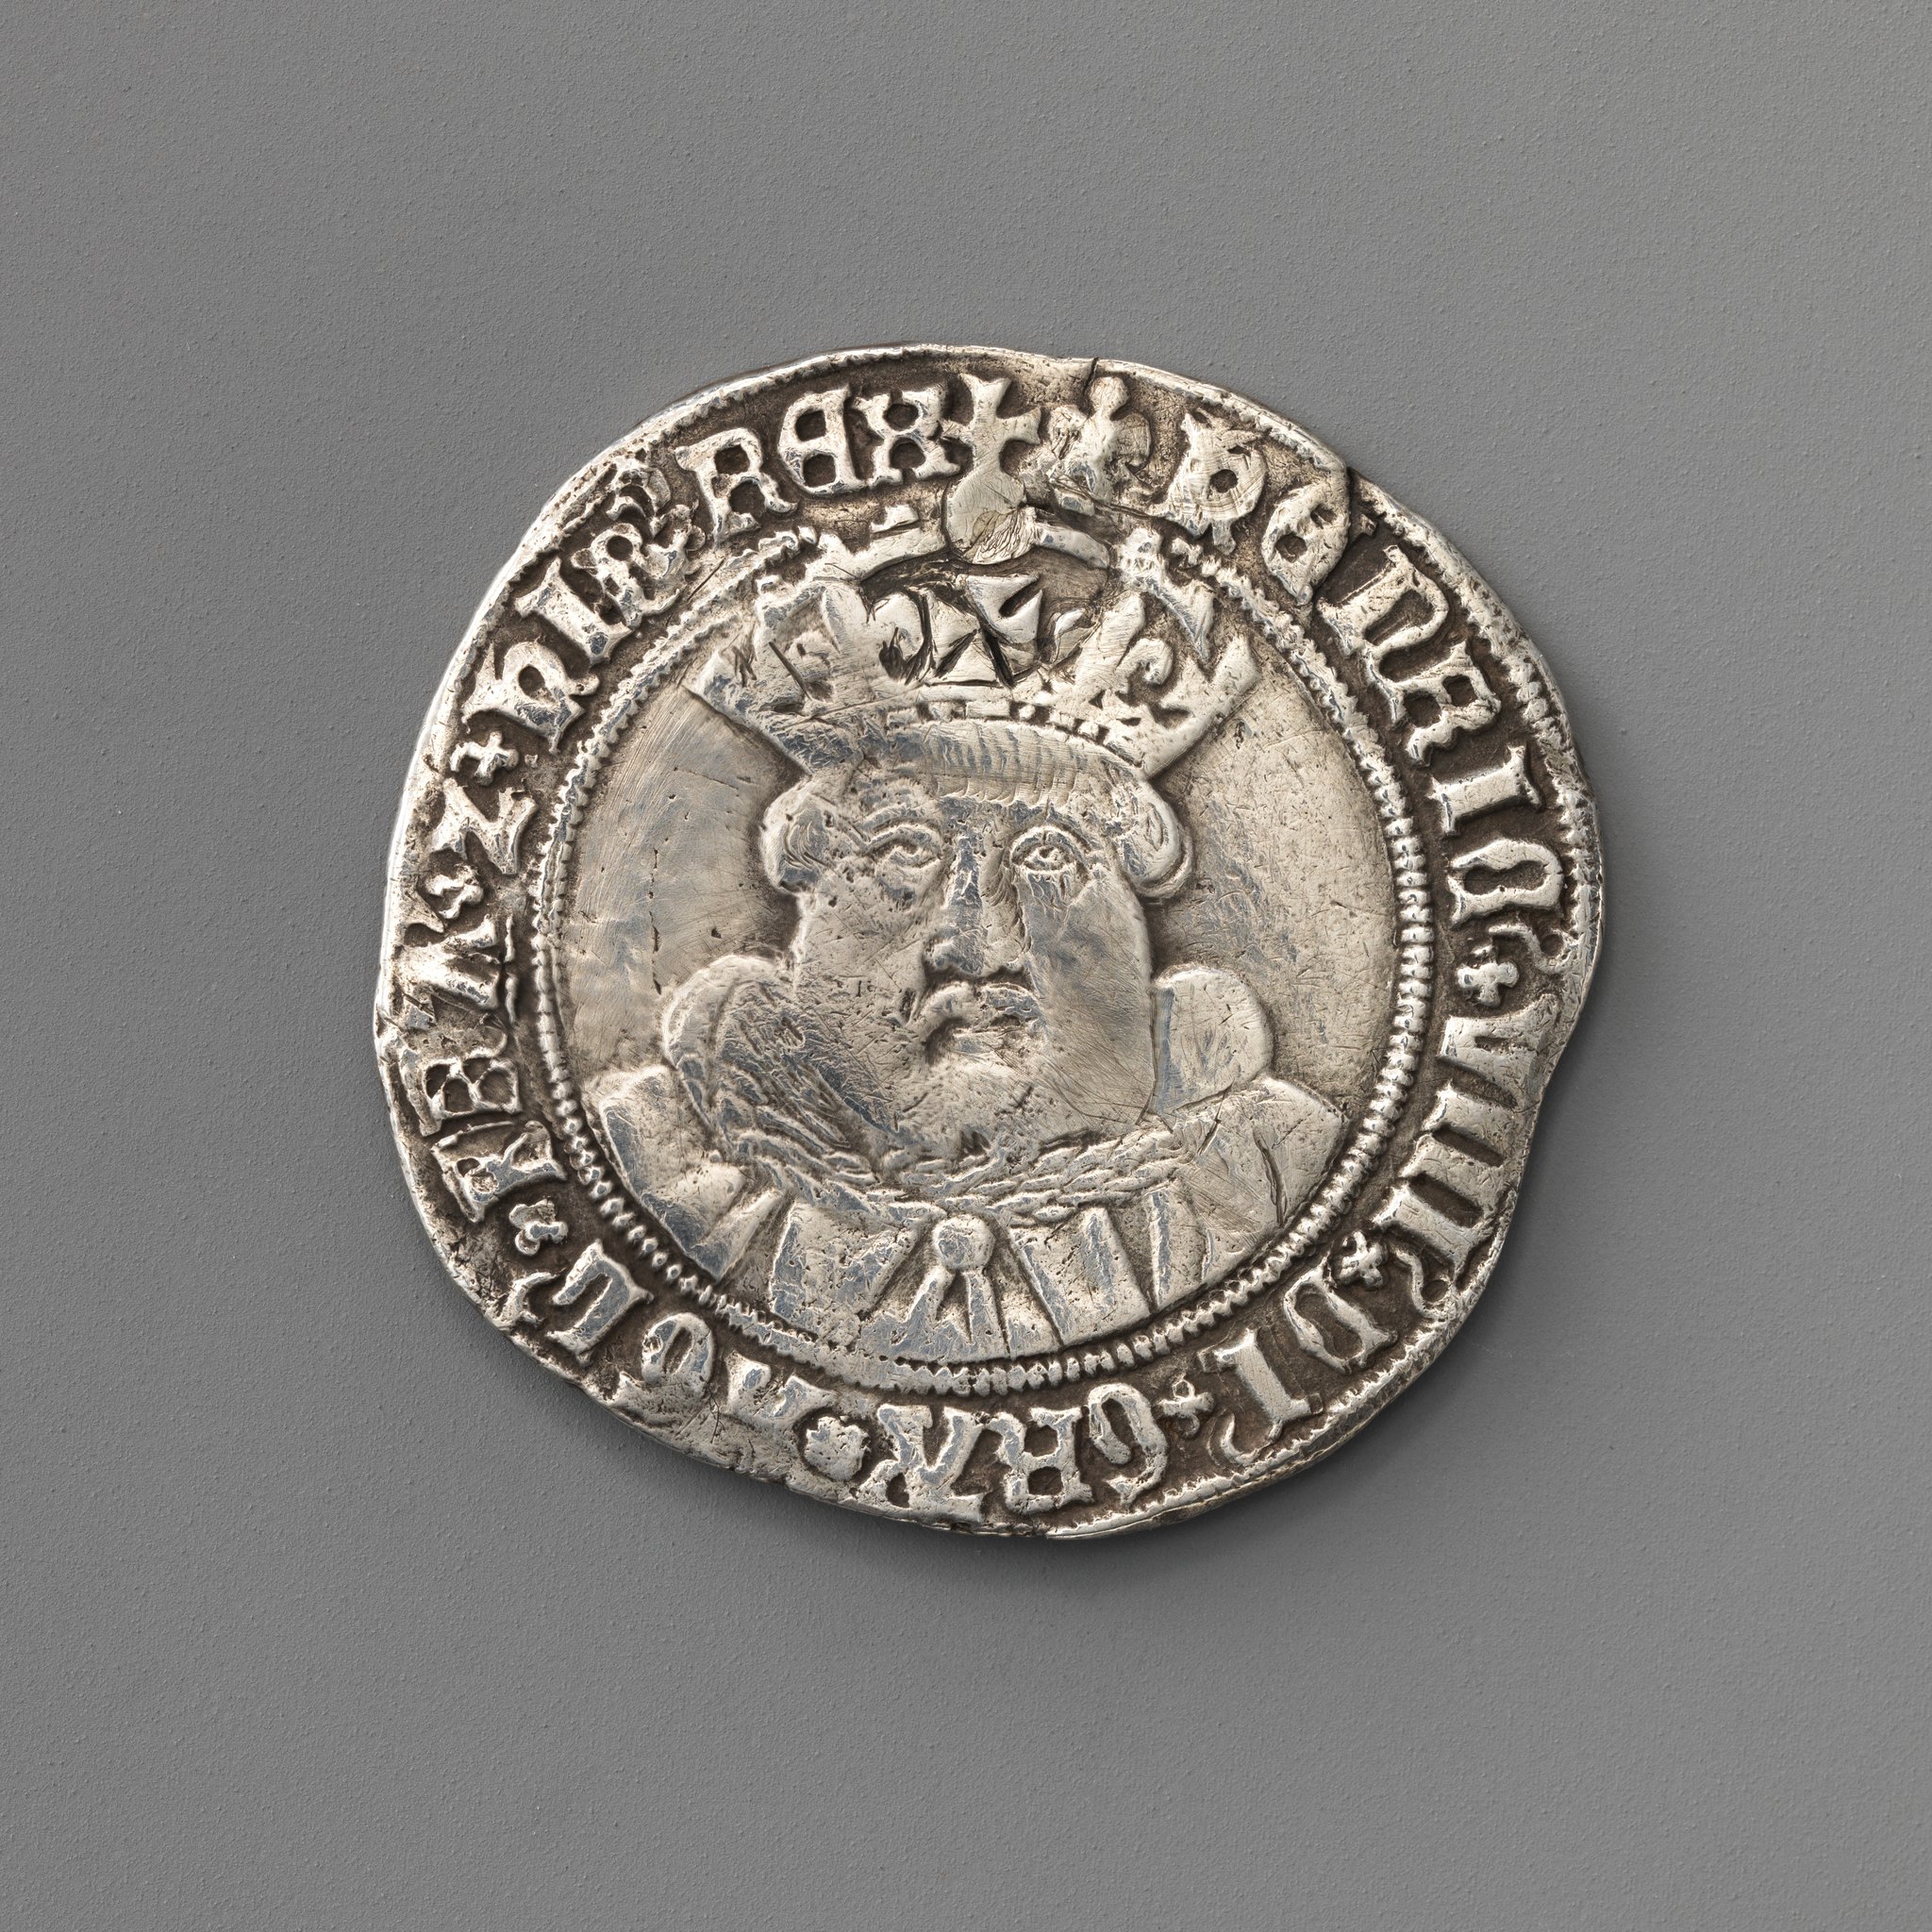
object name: testoon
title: Testoon of Henry VIII (third coinage)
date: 1509-1547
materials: silver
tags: henry viii,profiles,coins,insignia